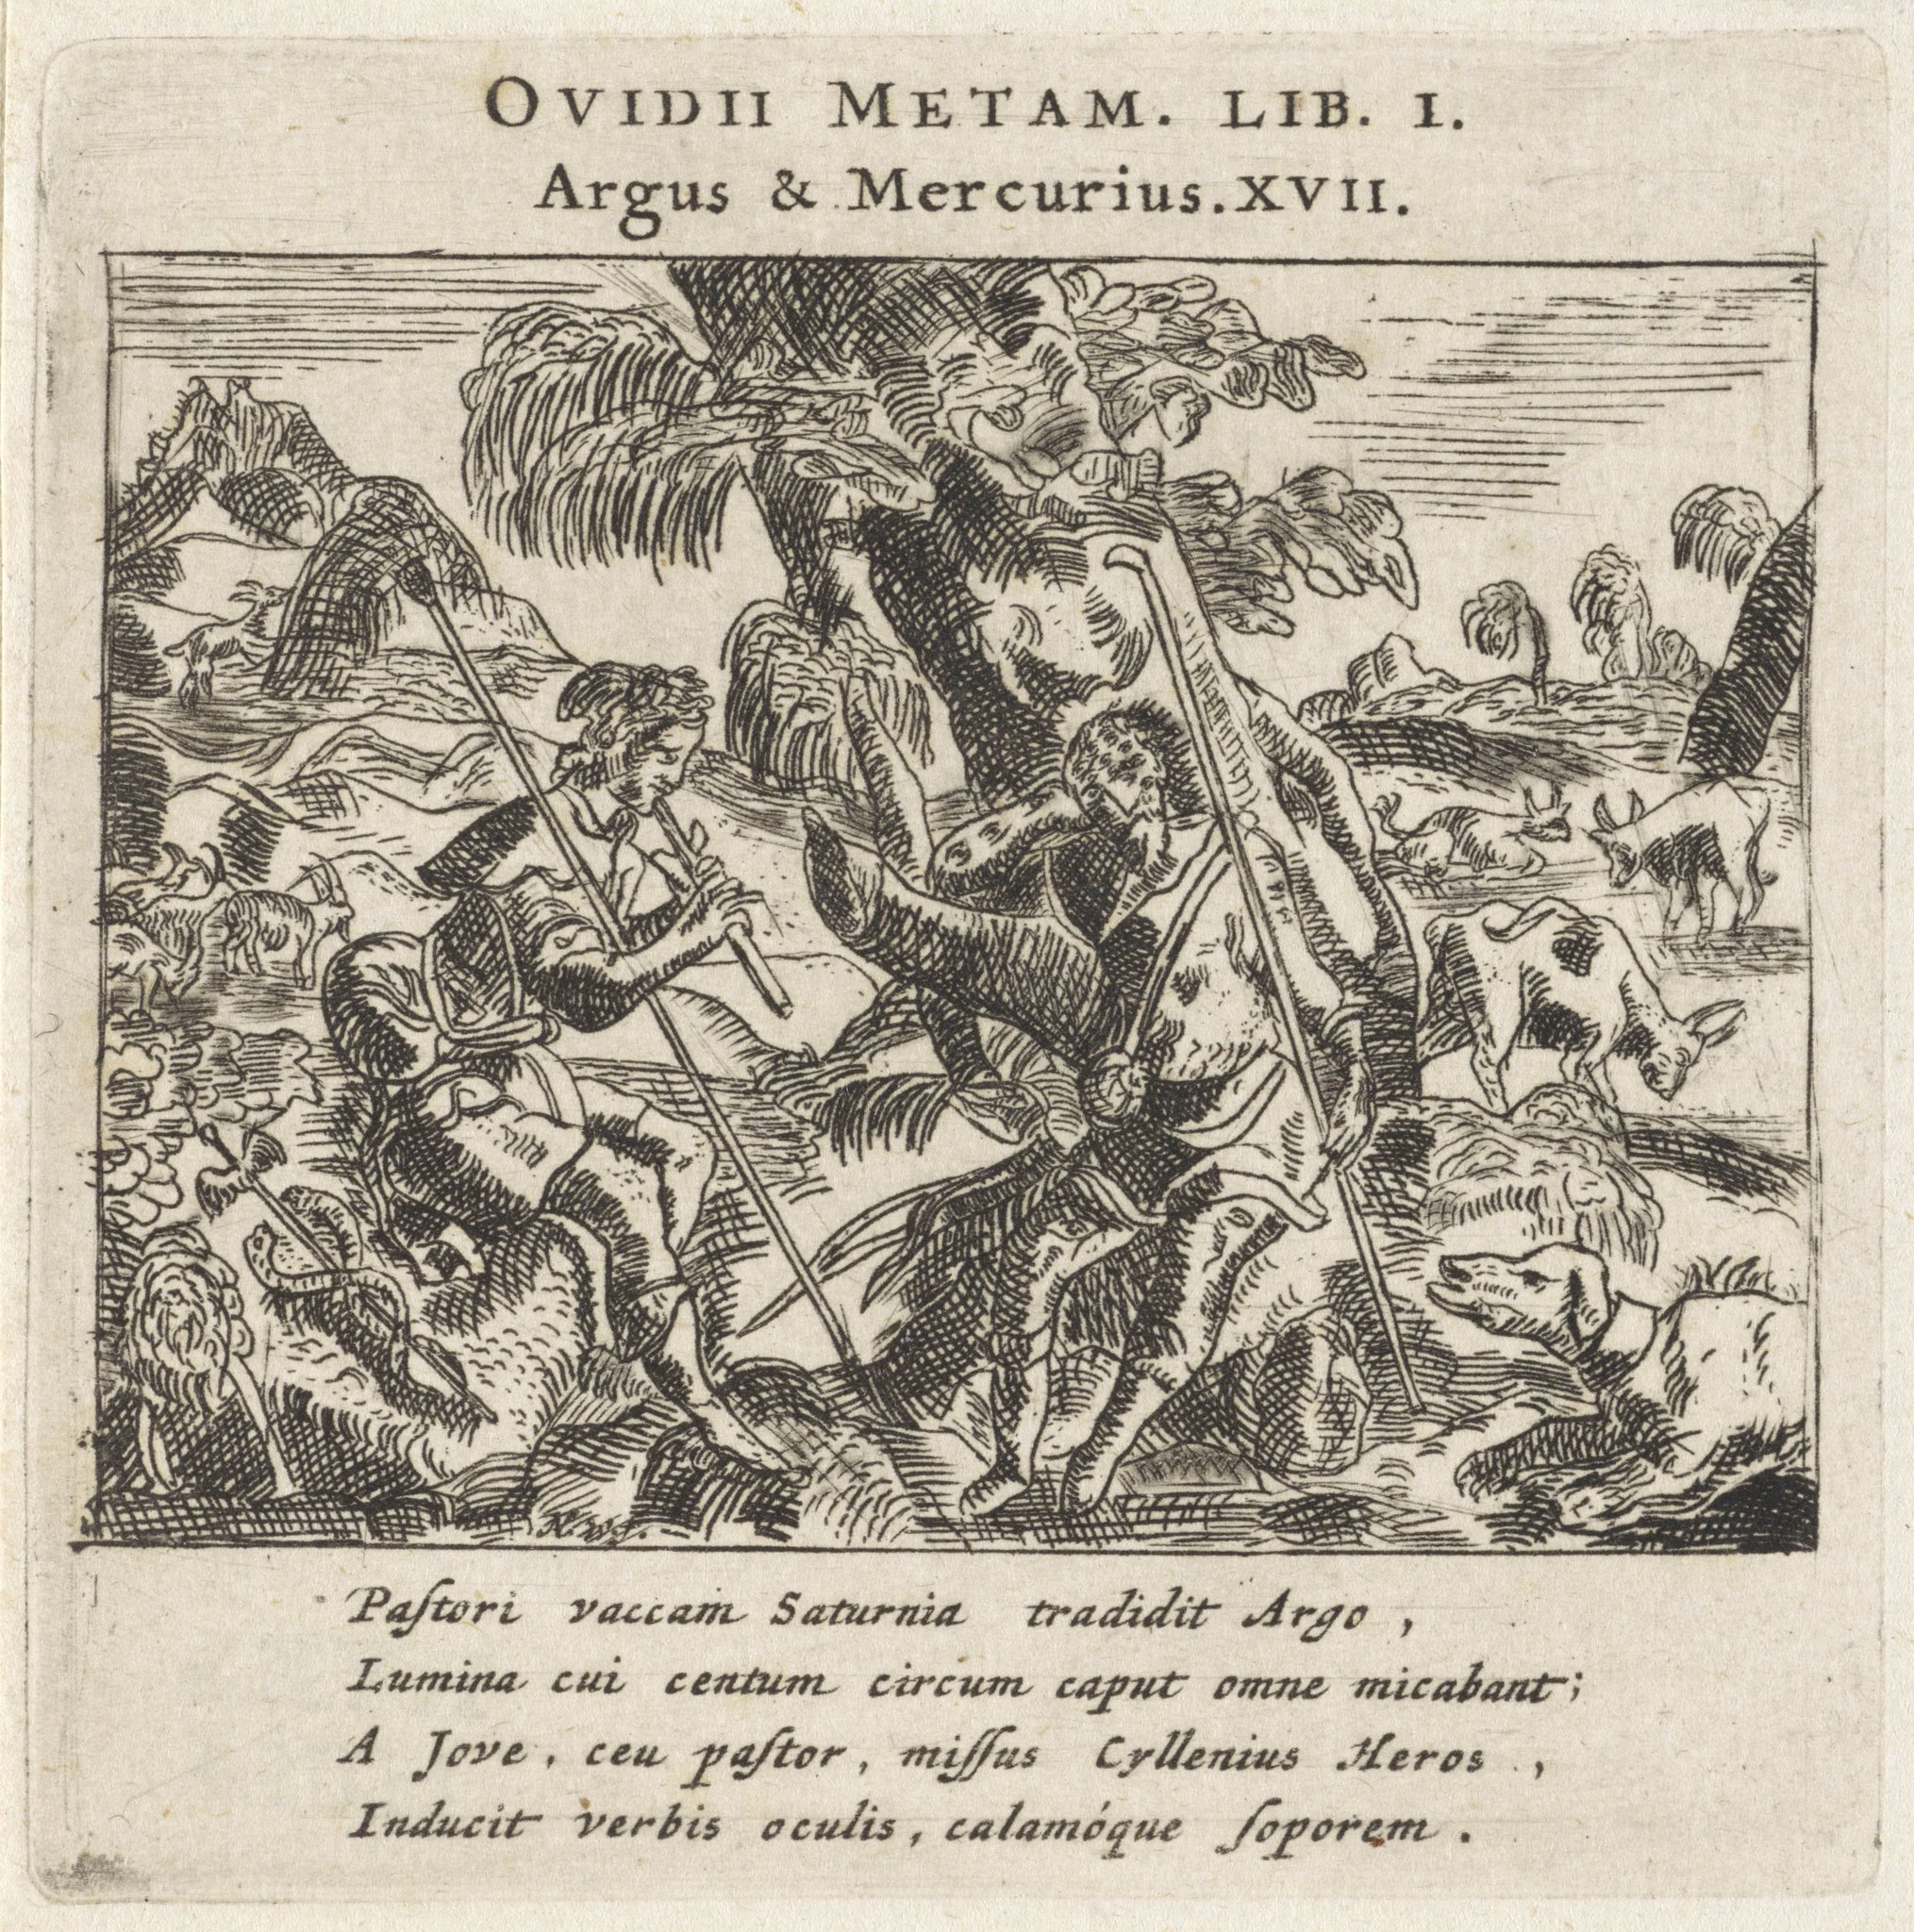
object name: print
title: Ovidii Metam. Lib. I Argus & Mercurius XVII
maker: nicolaes cornelisz. witsen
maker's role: mayor, print maker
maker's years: 1641-1717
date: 1659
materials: paper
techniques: etching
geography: amsterdam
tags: mercury lulls argus into sleep by making music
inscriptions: collector's mark: Lugt 2165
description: Mercurius sust Argus met zijn fluitspel in slaap. Achter hen grazen enkele koeien, waaronder Io, die door Argus bewaakt moest worden. Onder de voorstelling een vierregelige toelichting in het Latijn.